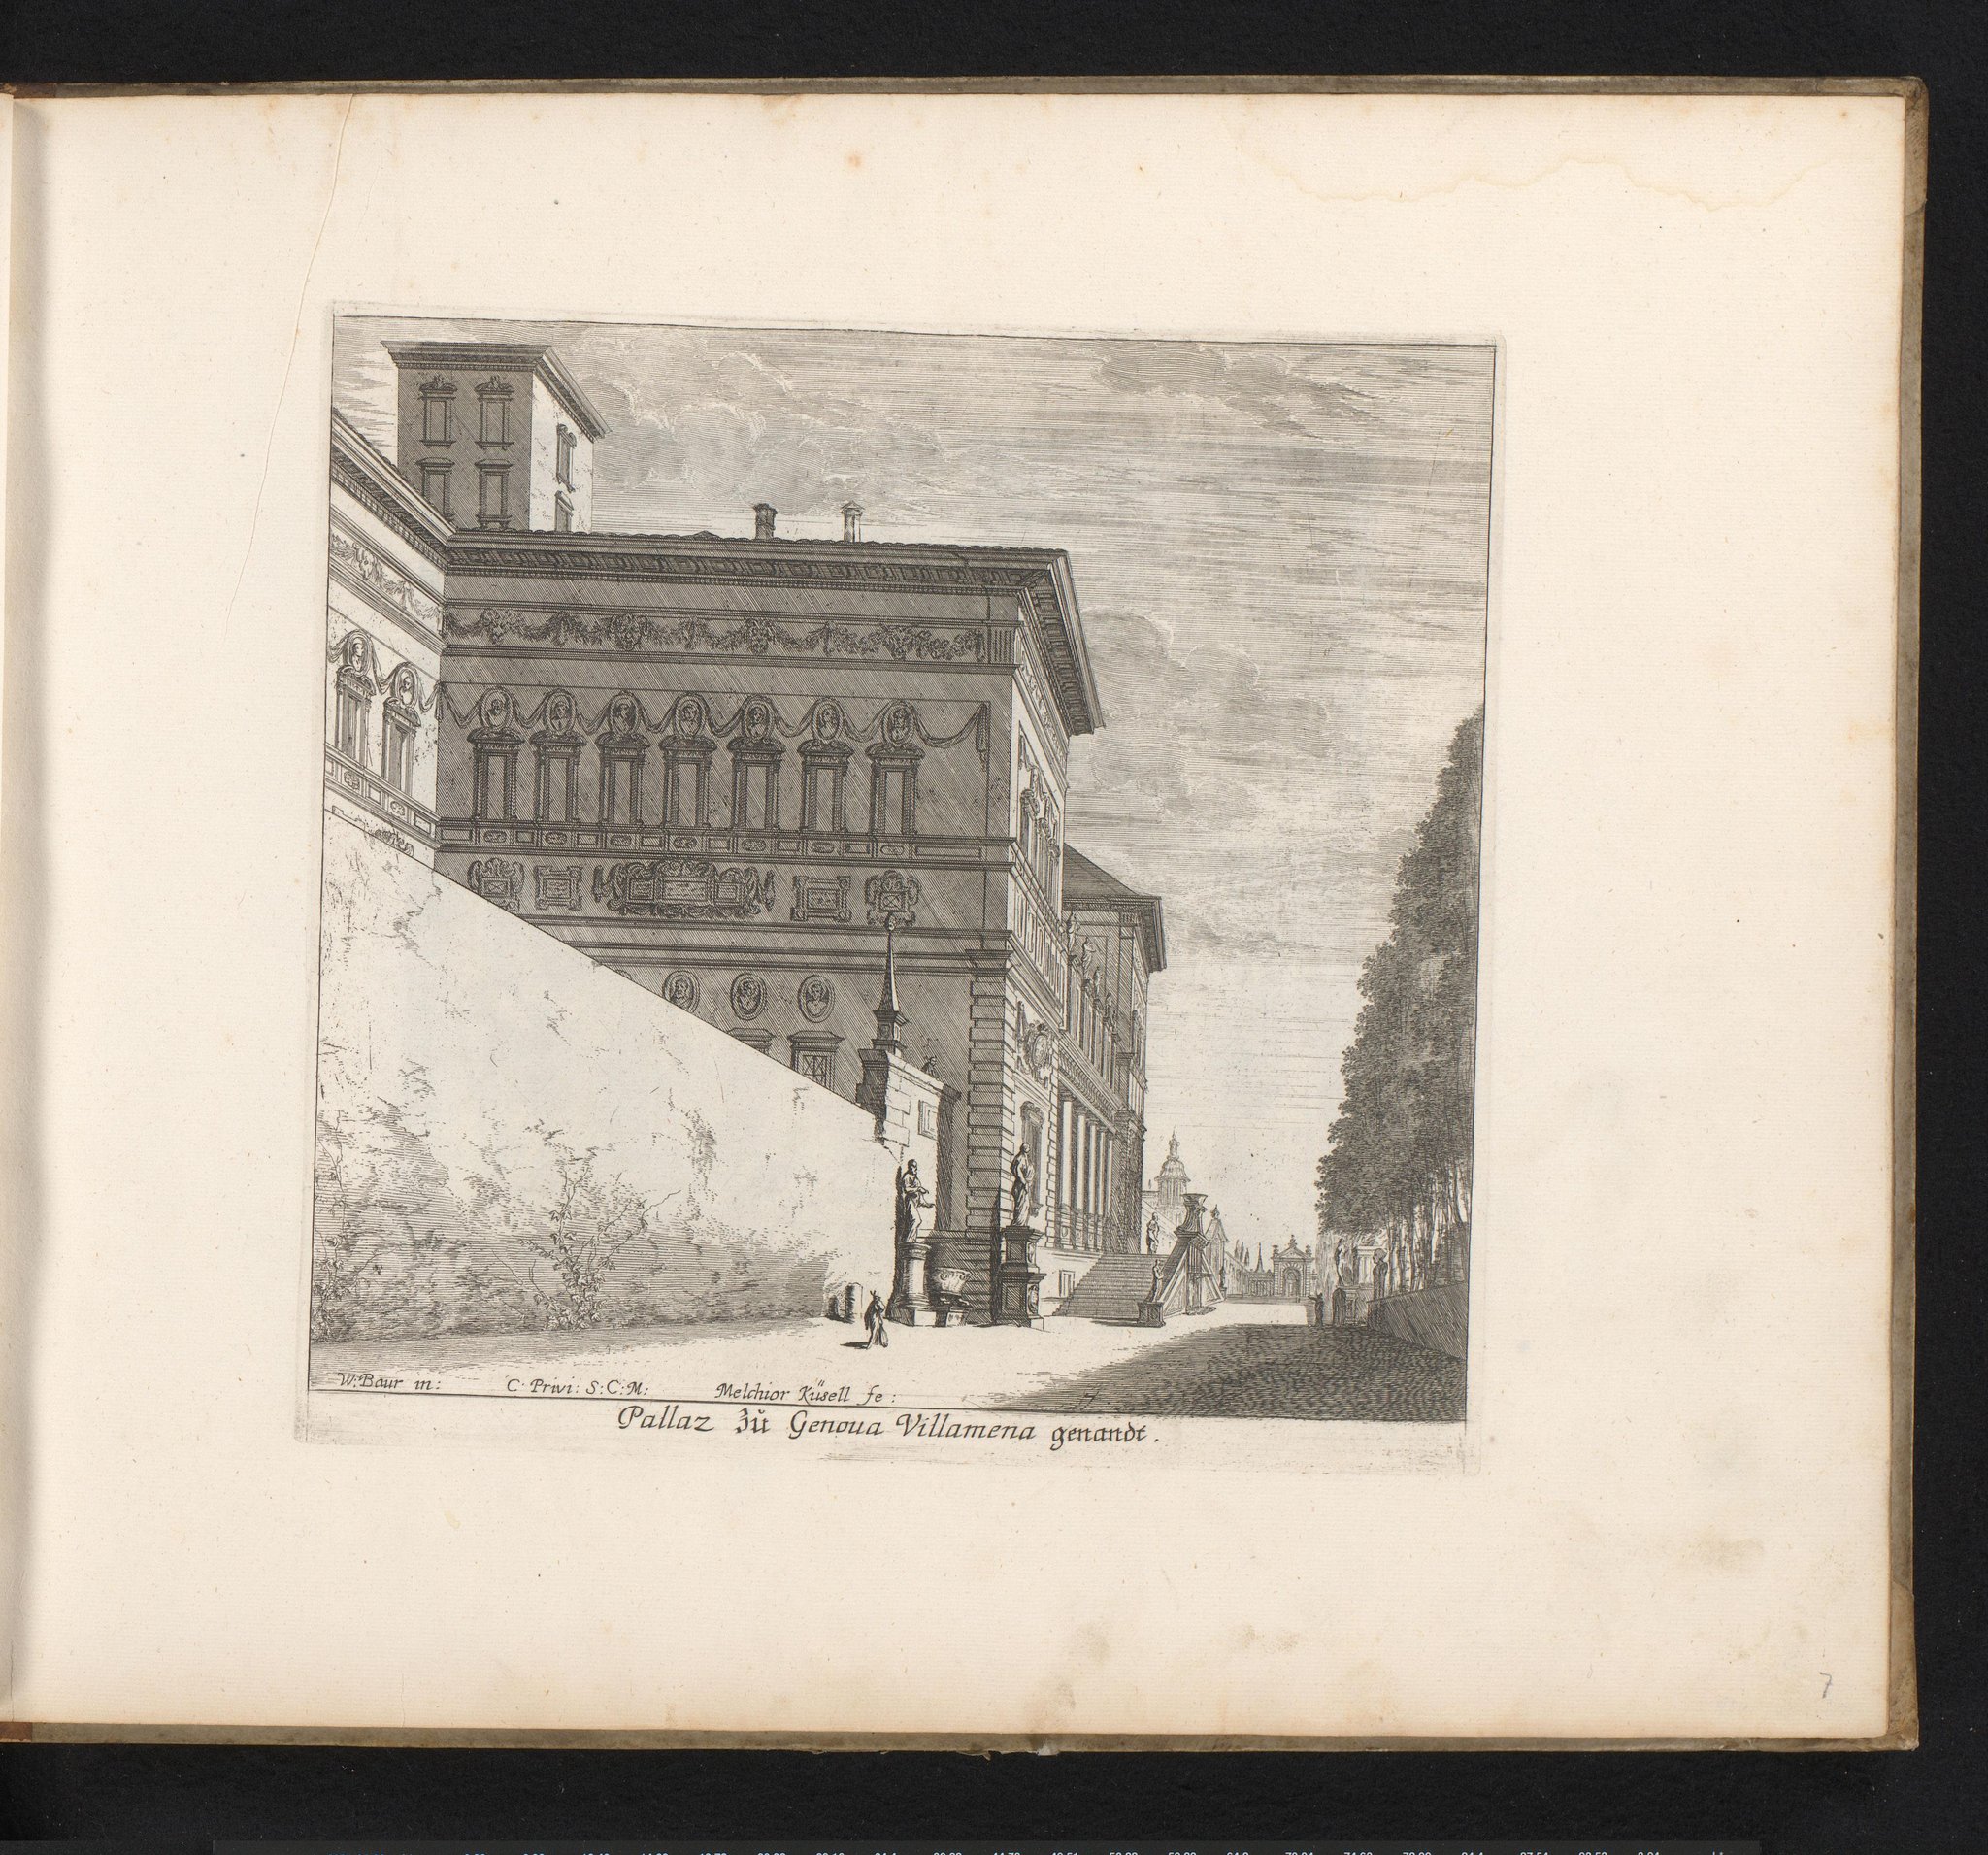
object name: album leaf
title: Landschap met water en bomen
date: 1670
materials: paper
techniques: etching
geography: augsburg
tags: rapids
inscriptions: collector's mark: Lugt 2228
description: Tekst in het Duits in de ondermarge. Rechtsonder genummerd: 6. Prent maakt deel uit van een album.